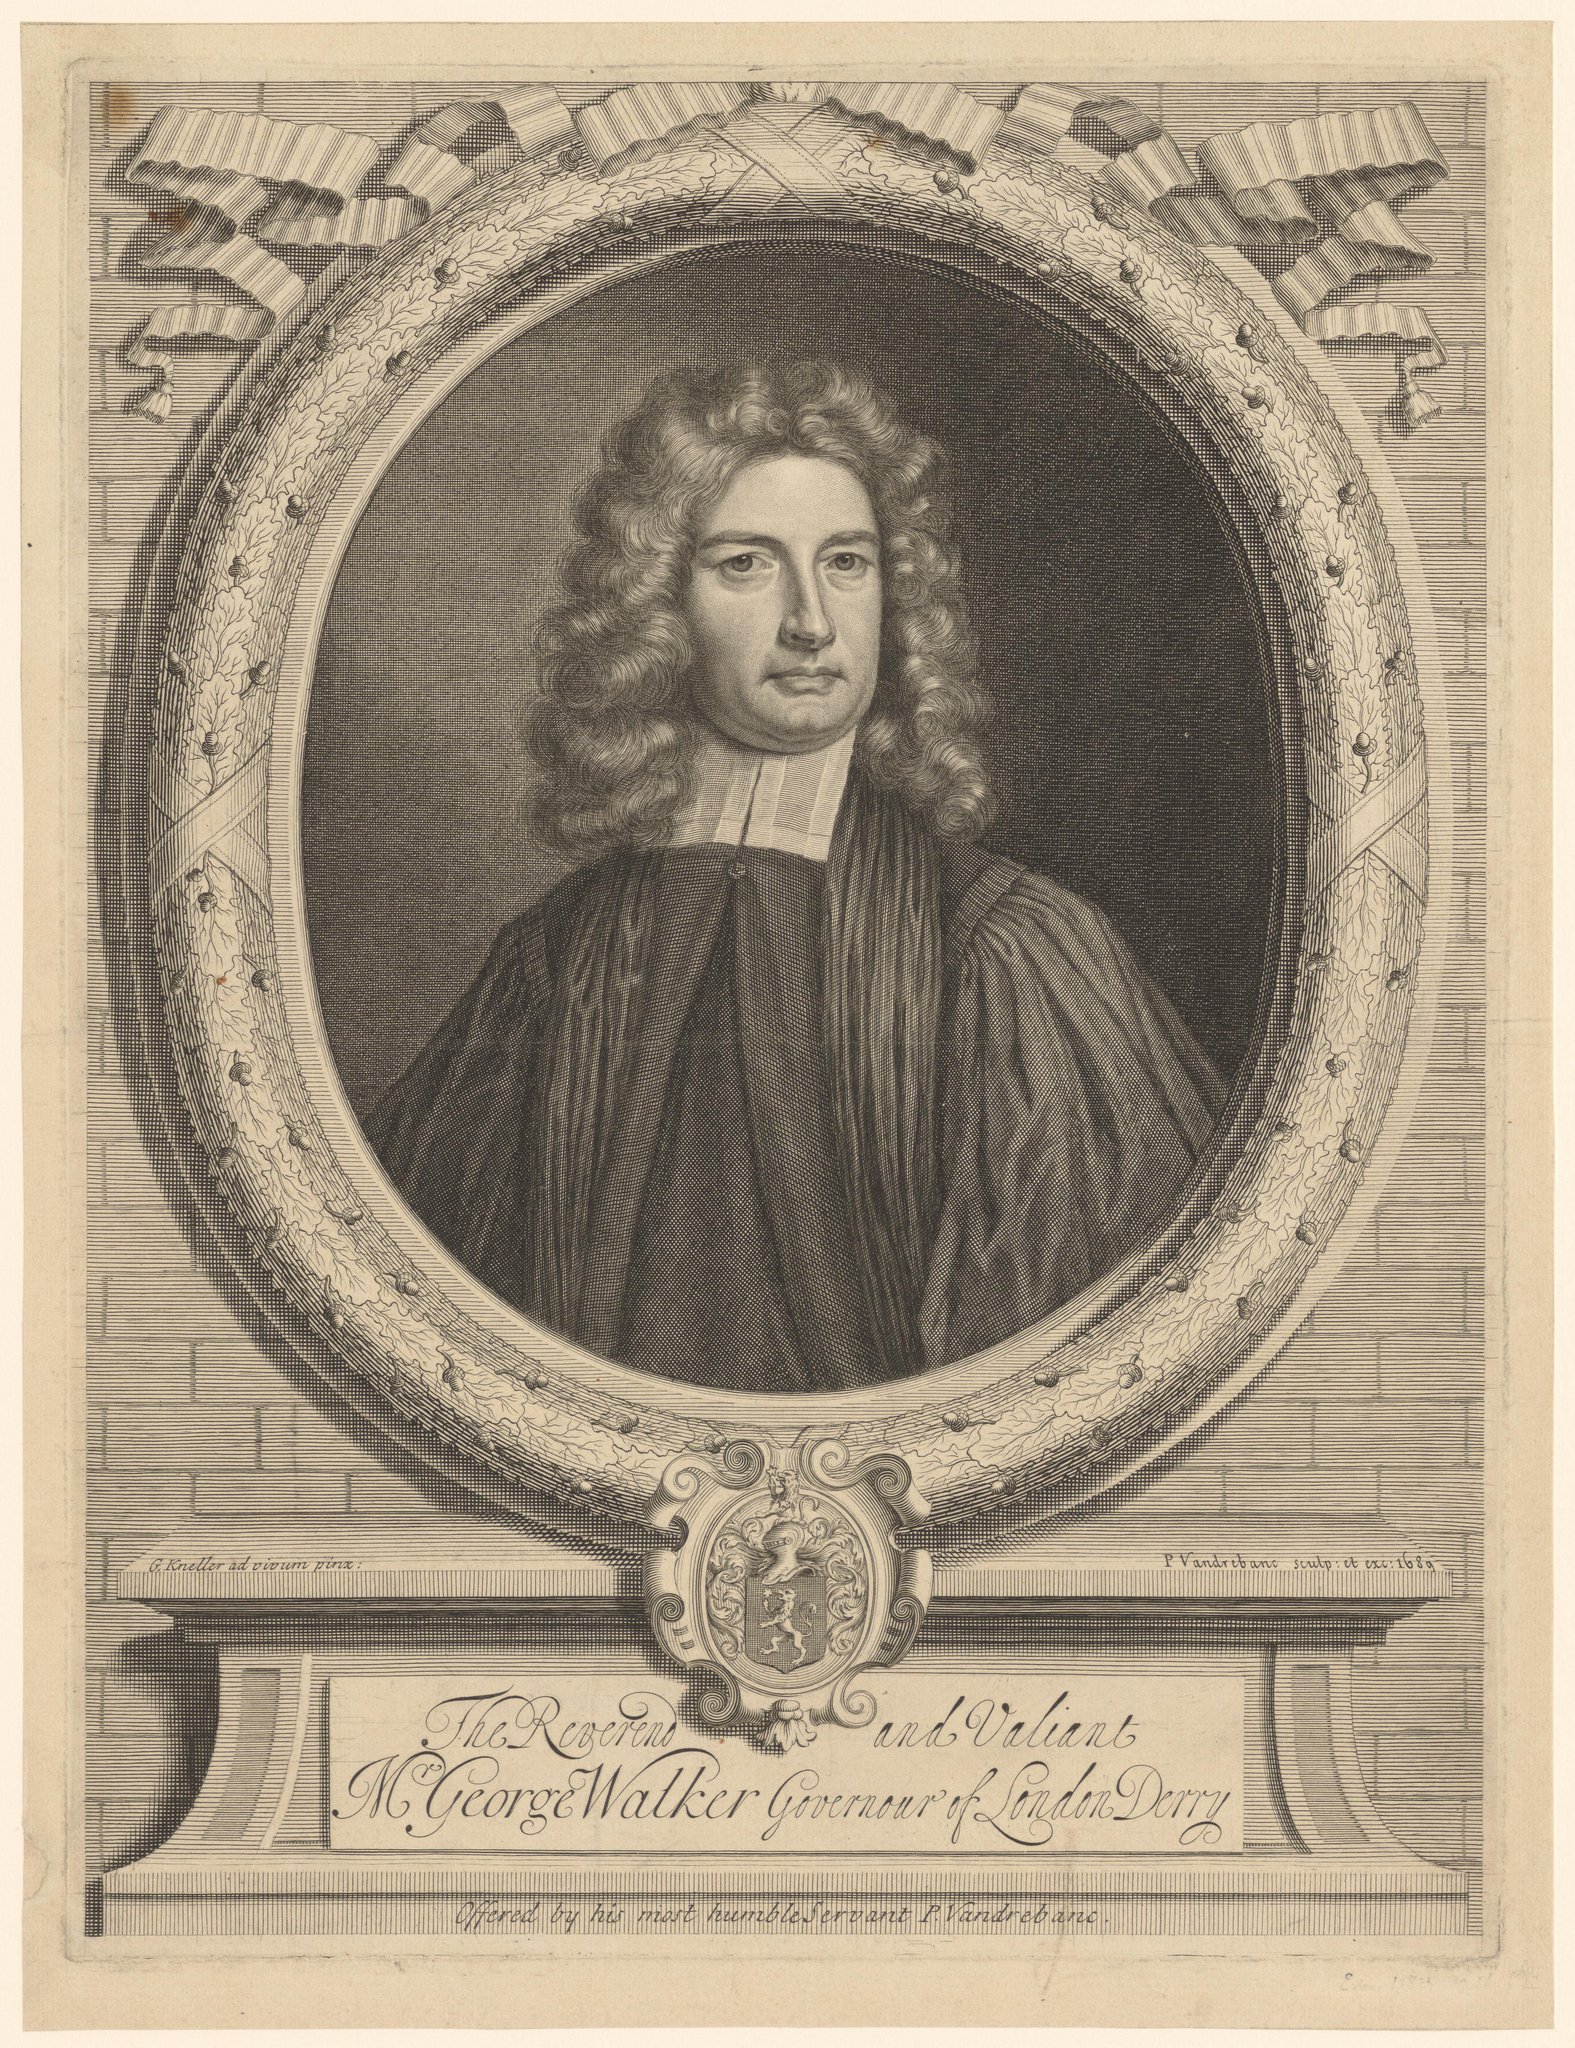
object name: print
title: Portret van George Walker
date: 1689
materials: paper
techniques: engraving, etching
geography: london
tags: george walker, historical persons, functionaries and dignitaries (with name) ~ protestant churches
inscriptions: collector's mark: Lugt 2228